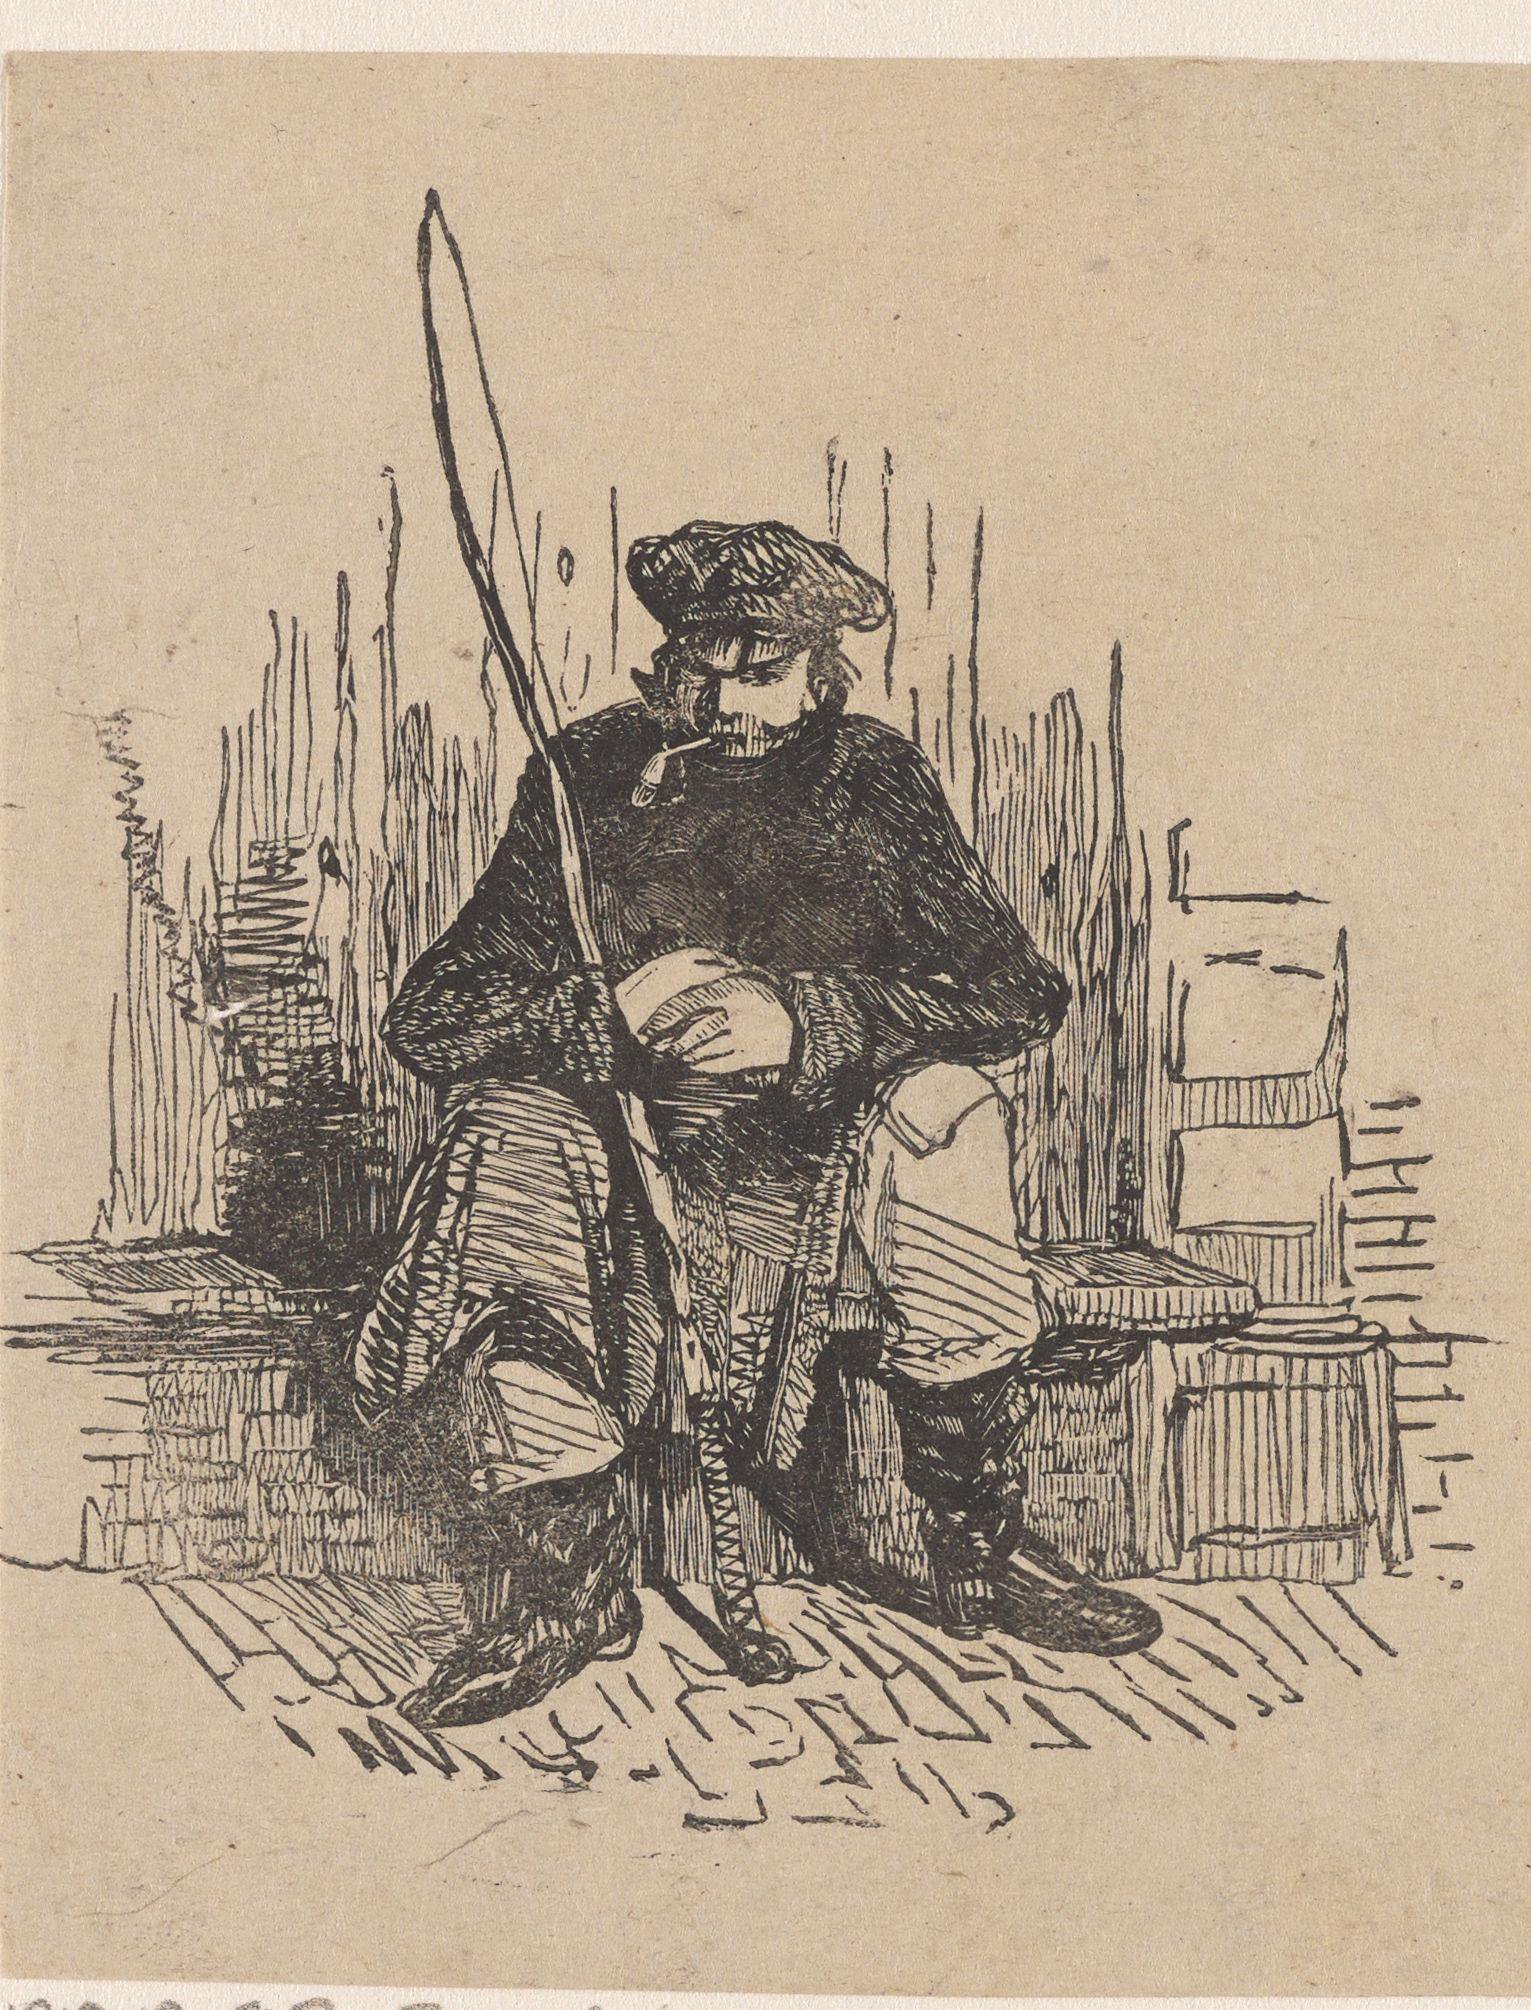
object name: print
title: Zittende visser met een hengel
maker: isaac weissenbruch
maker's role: print maker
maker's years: 1826-1912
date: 1836-1912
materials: paper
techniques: engraving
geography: netherlands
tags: fisherman